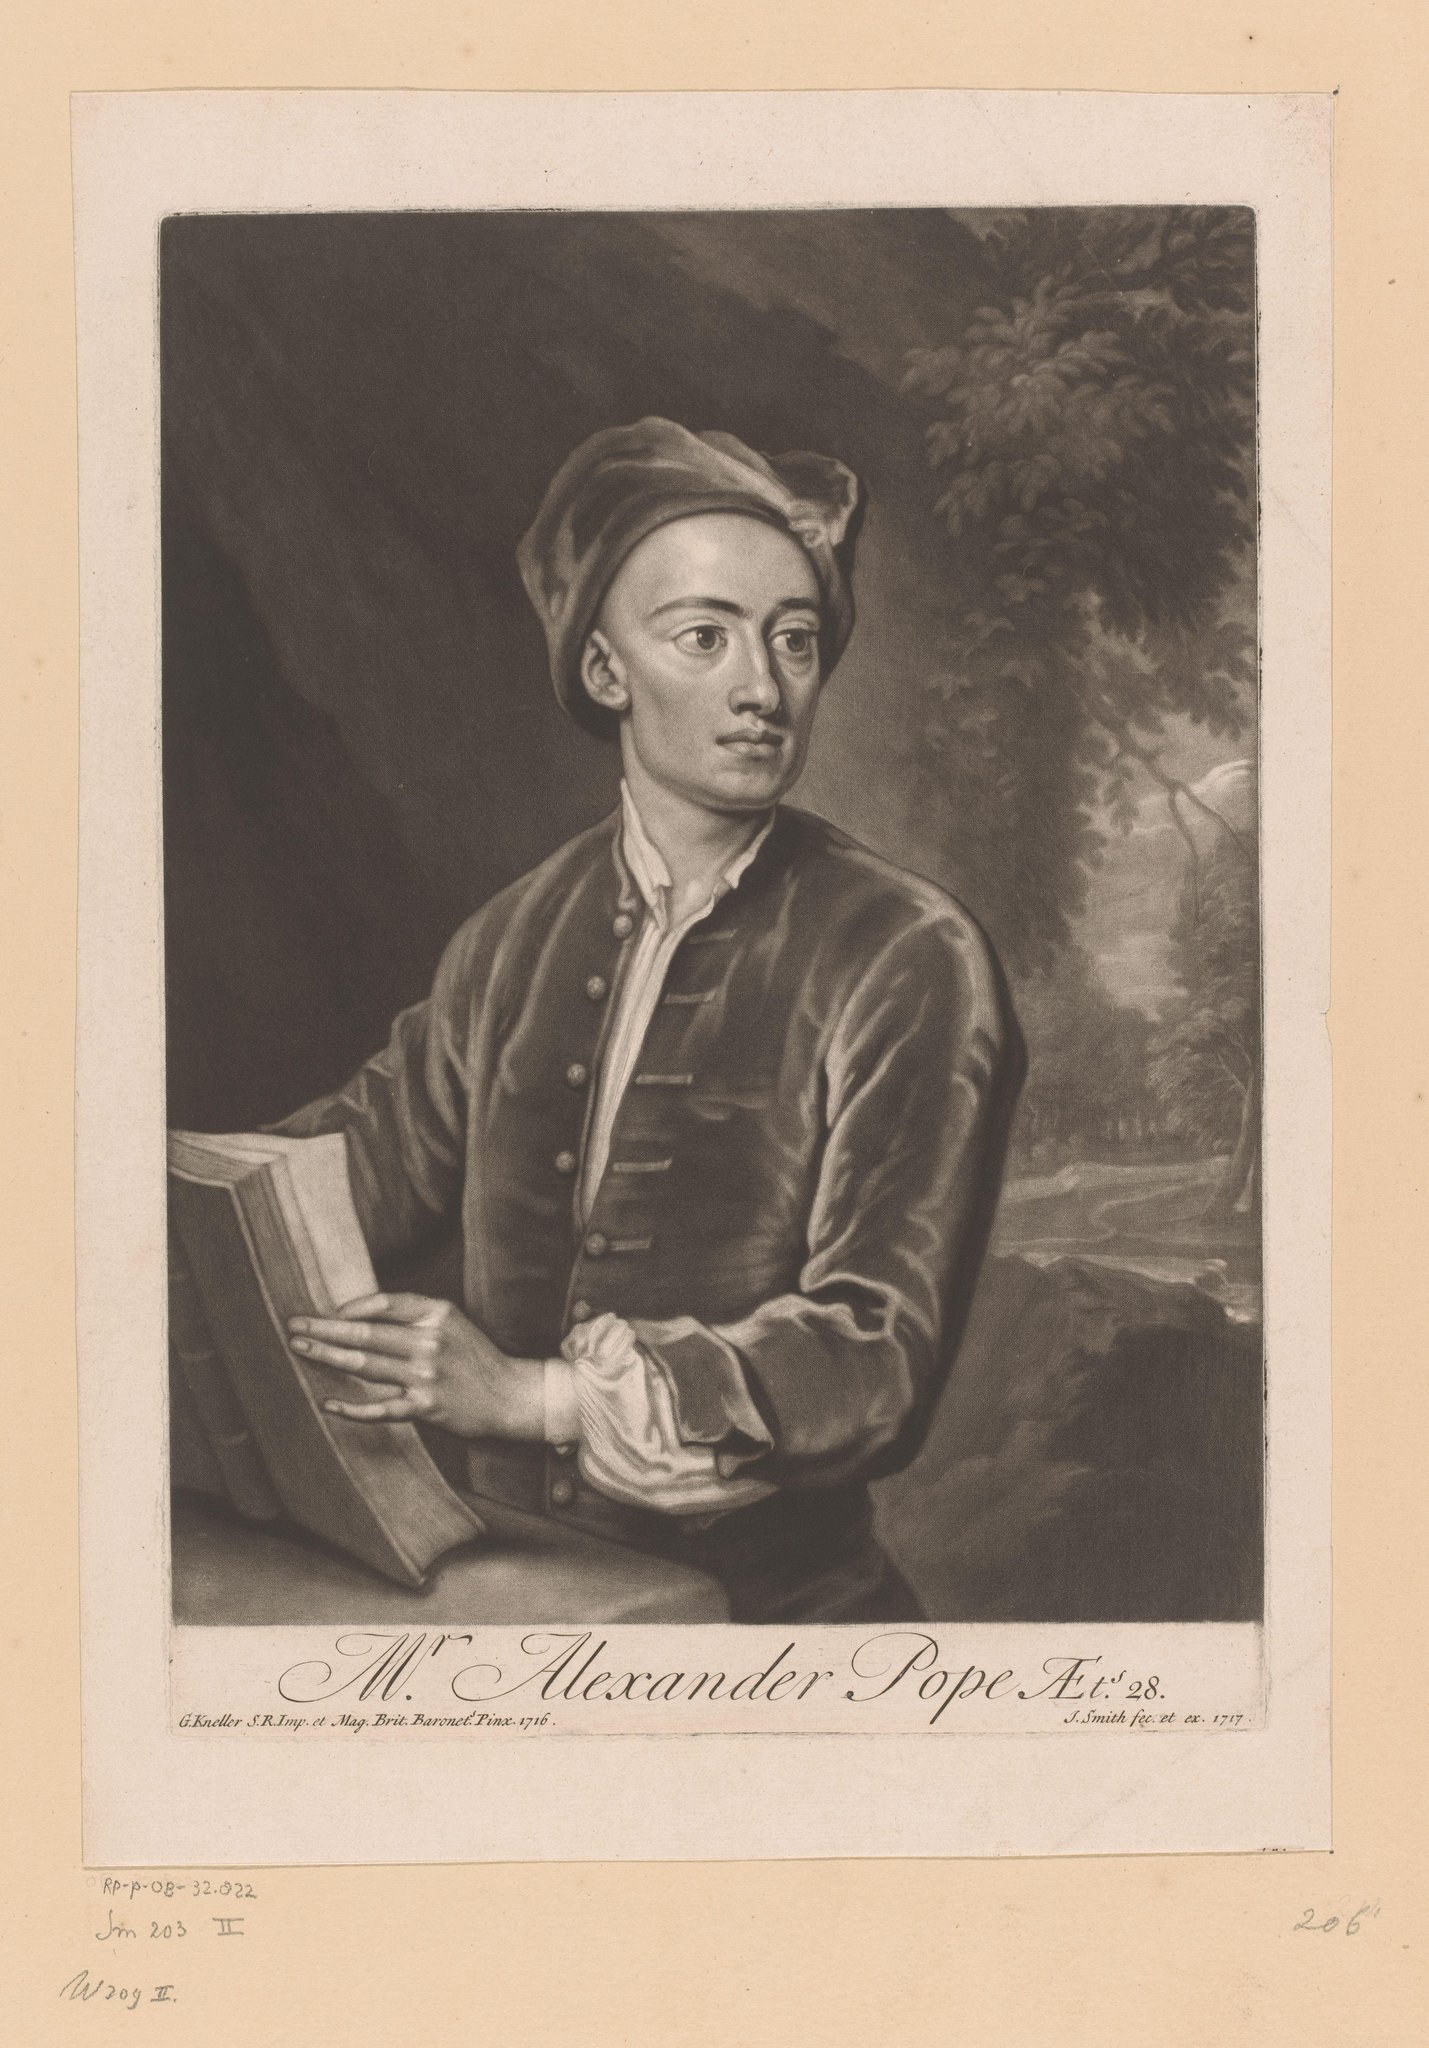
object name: print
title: Portret van Alexander Pope op 28-jarige leeftijd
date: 1717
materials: paper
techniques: mezzotint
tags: london, alexander pope, historical persons, writer, poet, author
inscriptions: collector's mark: Lugt 240